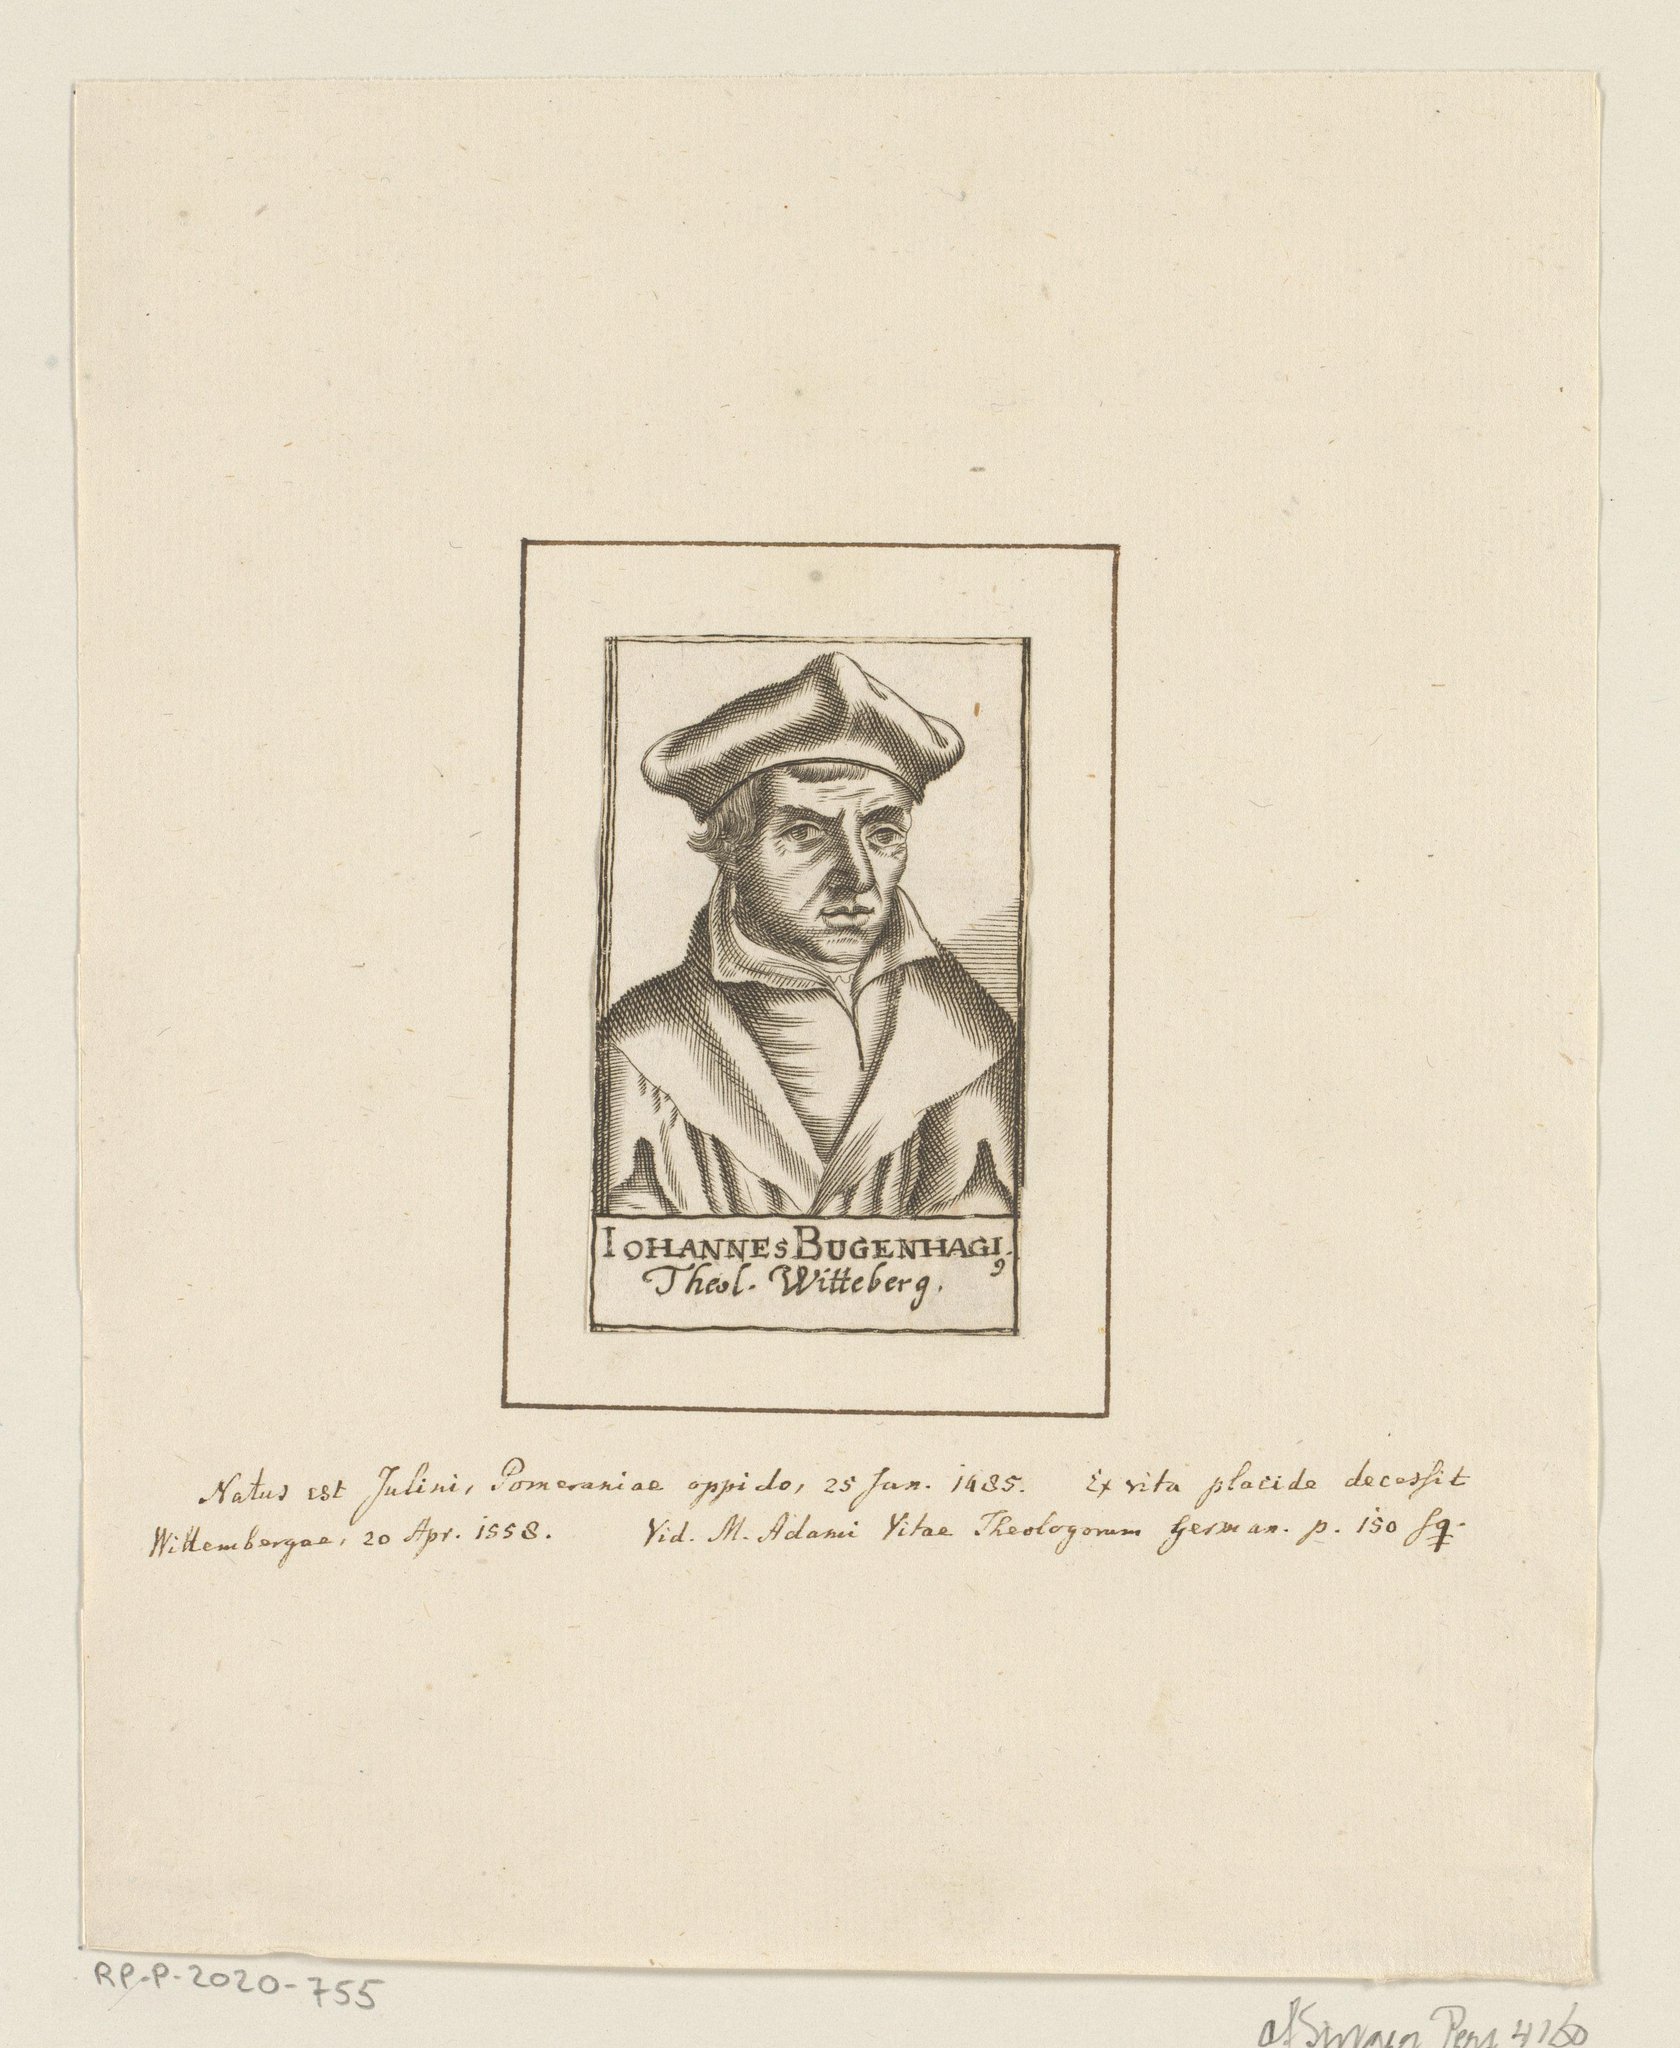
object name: print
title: Portret van Johannes Bugenhagen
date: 1688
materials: paper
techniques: engraving, etching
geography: nuremberg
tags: theologian, historical persons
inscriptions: inscription: ‘Natus Ist julini, Pomeraniae (...)’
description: Prent uit: Freher, Paul. Theatrum virorum eruditione clarorum. Neurenberg: Johann Hoffmann, 1688.